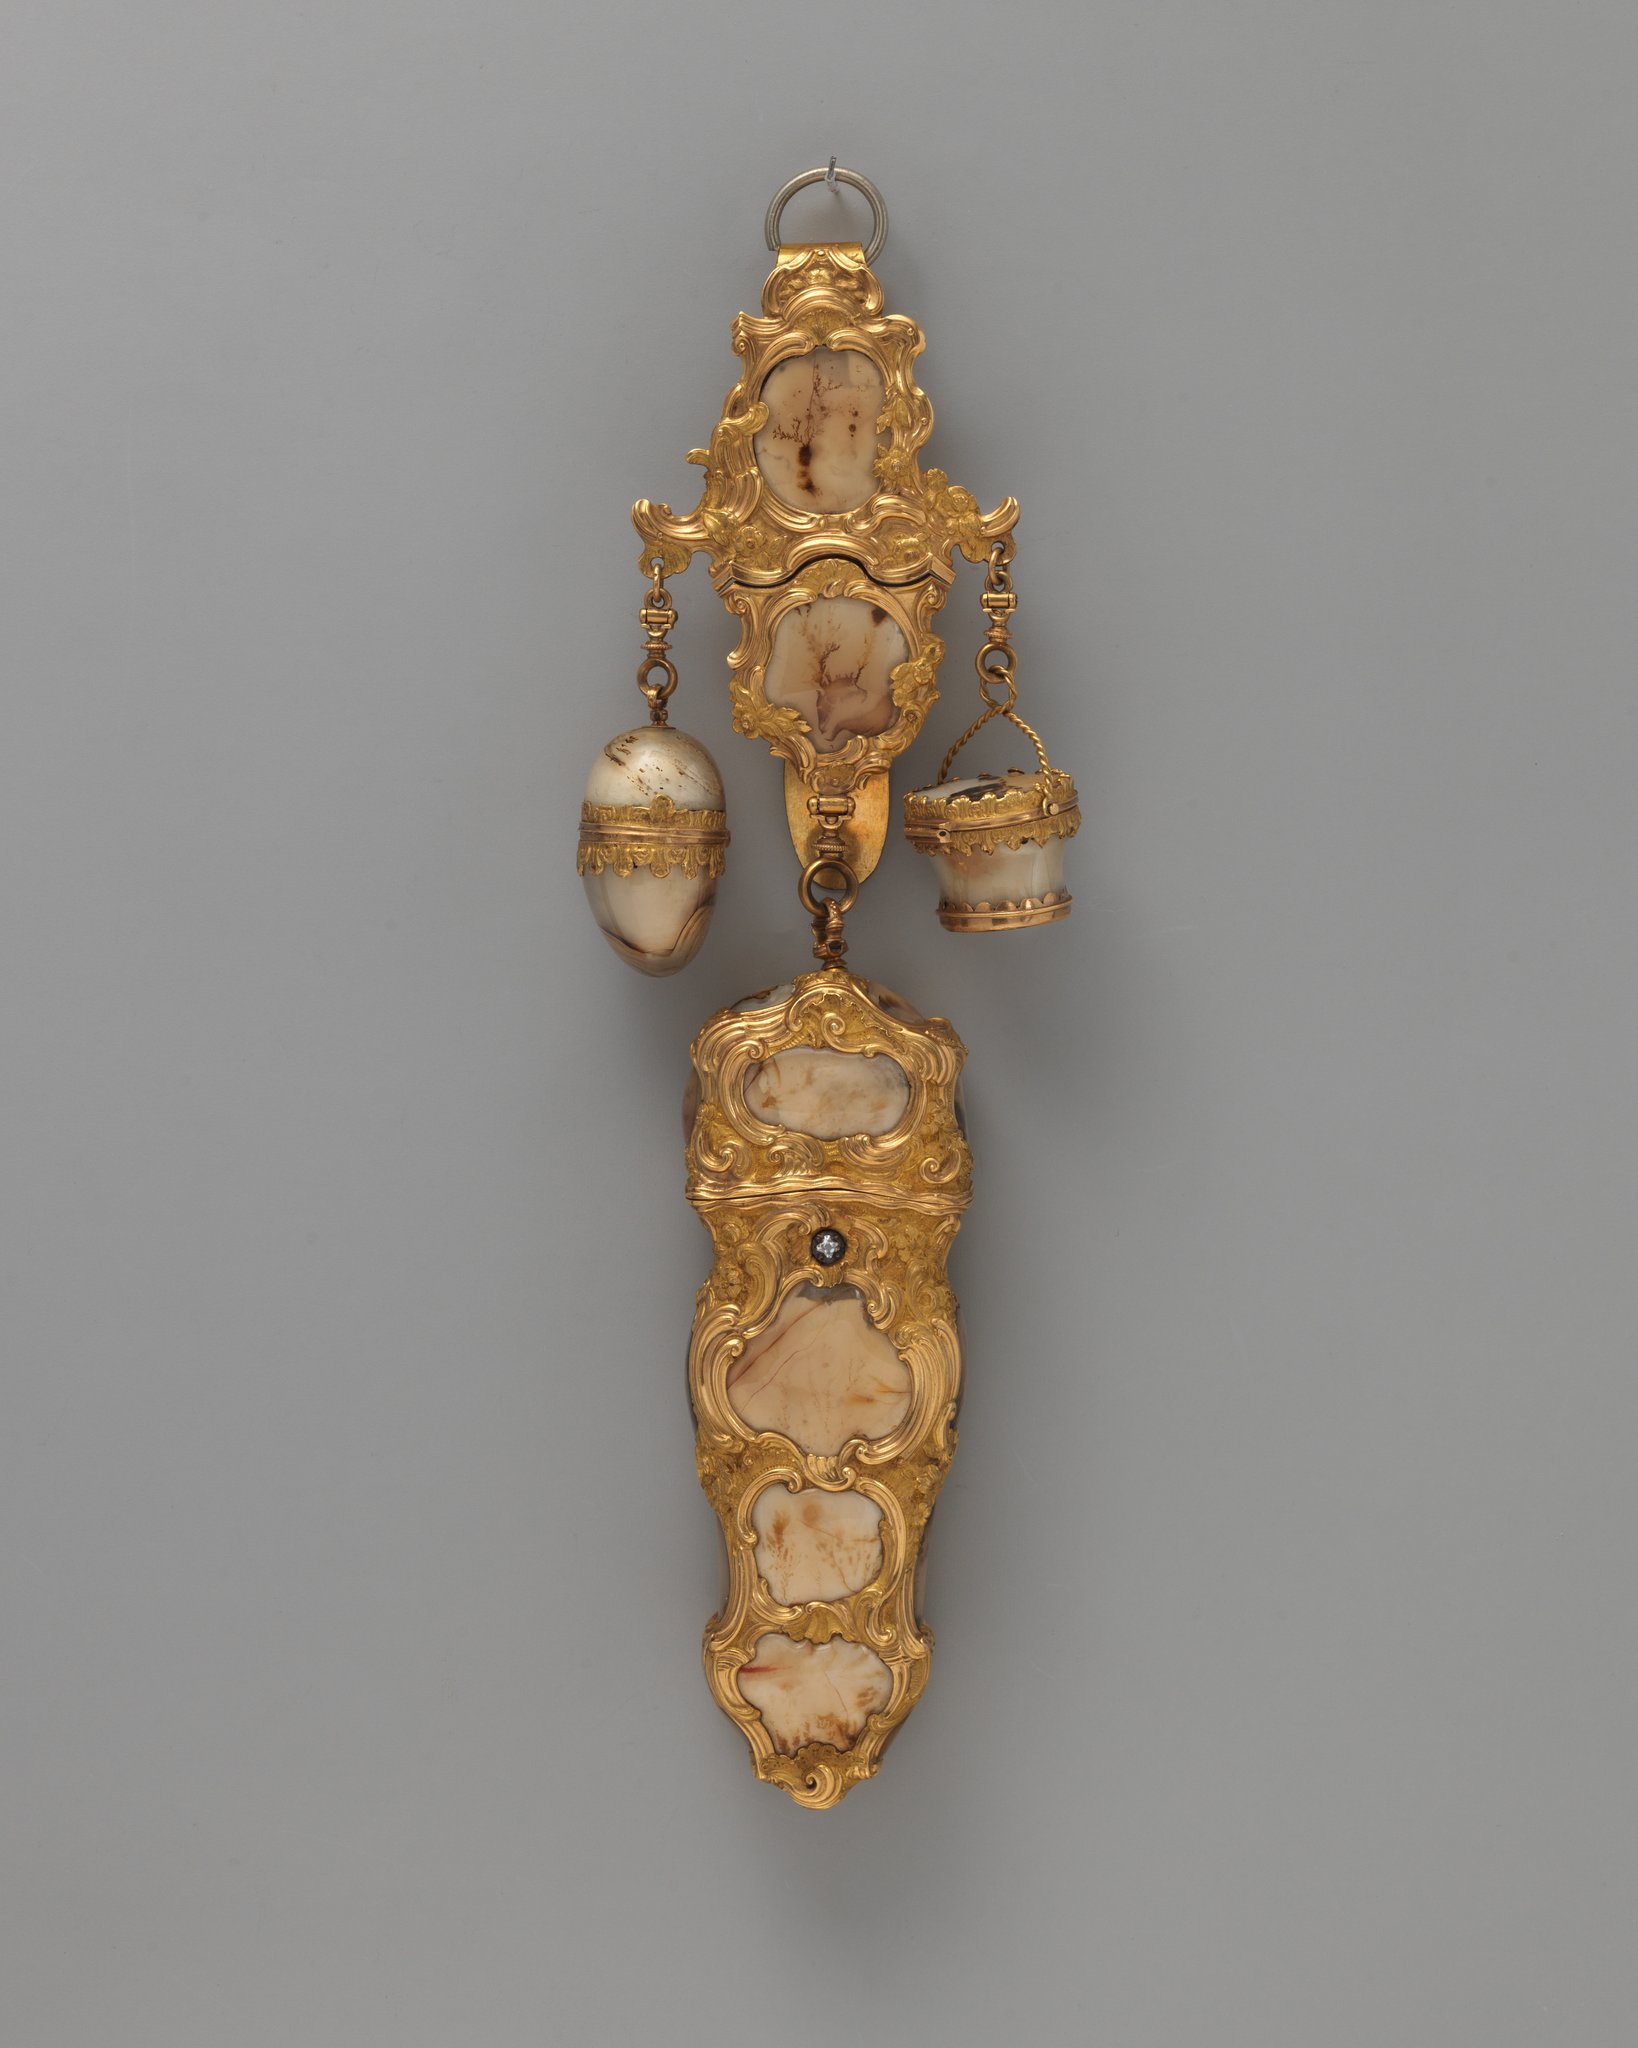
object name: chatelaine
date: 1750-1760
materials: stone, gold